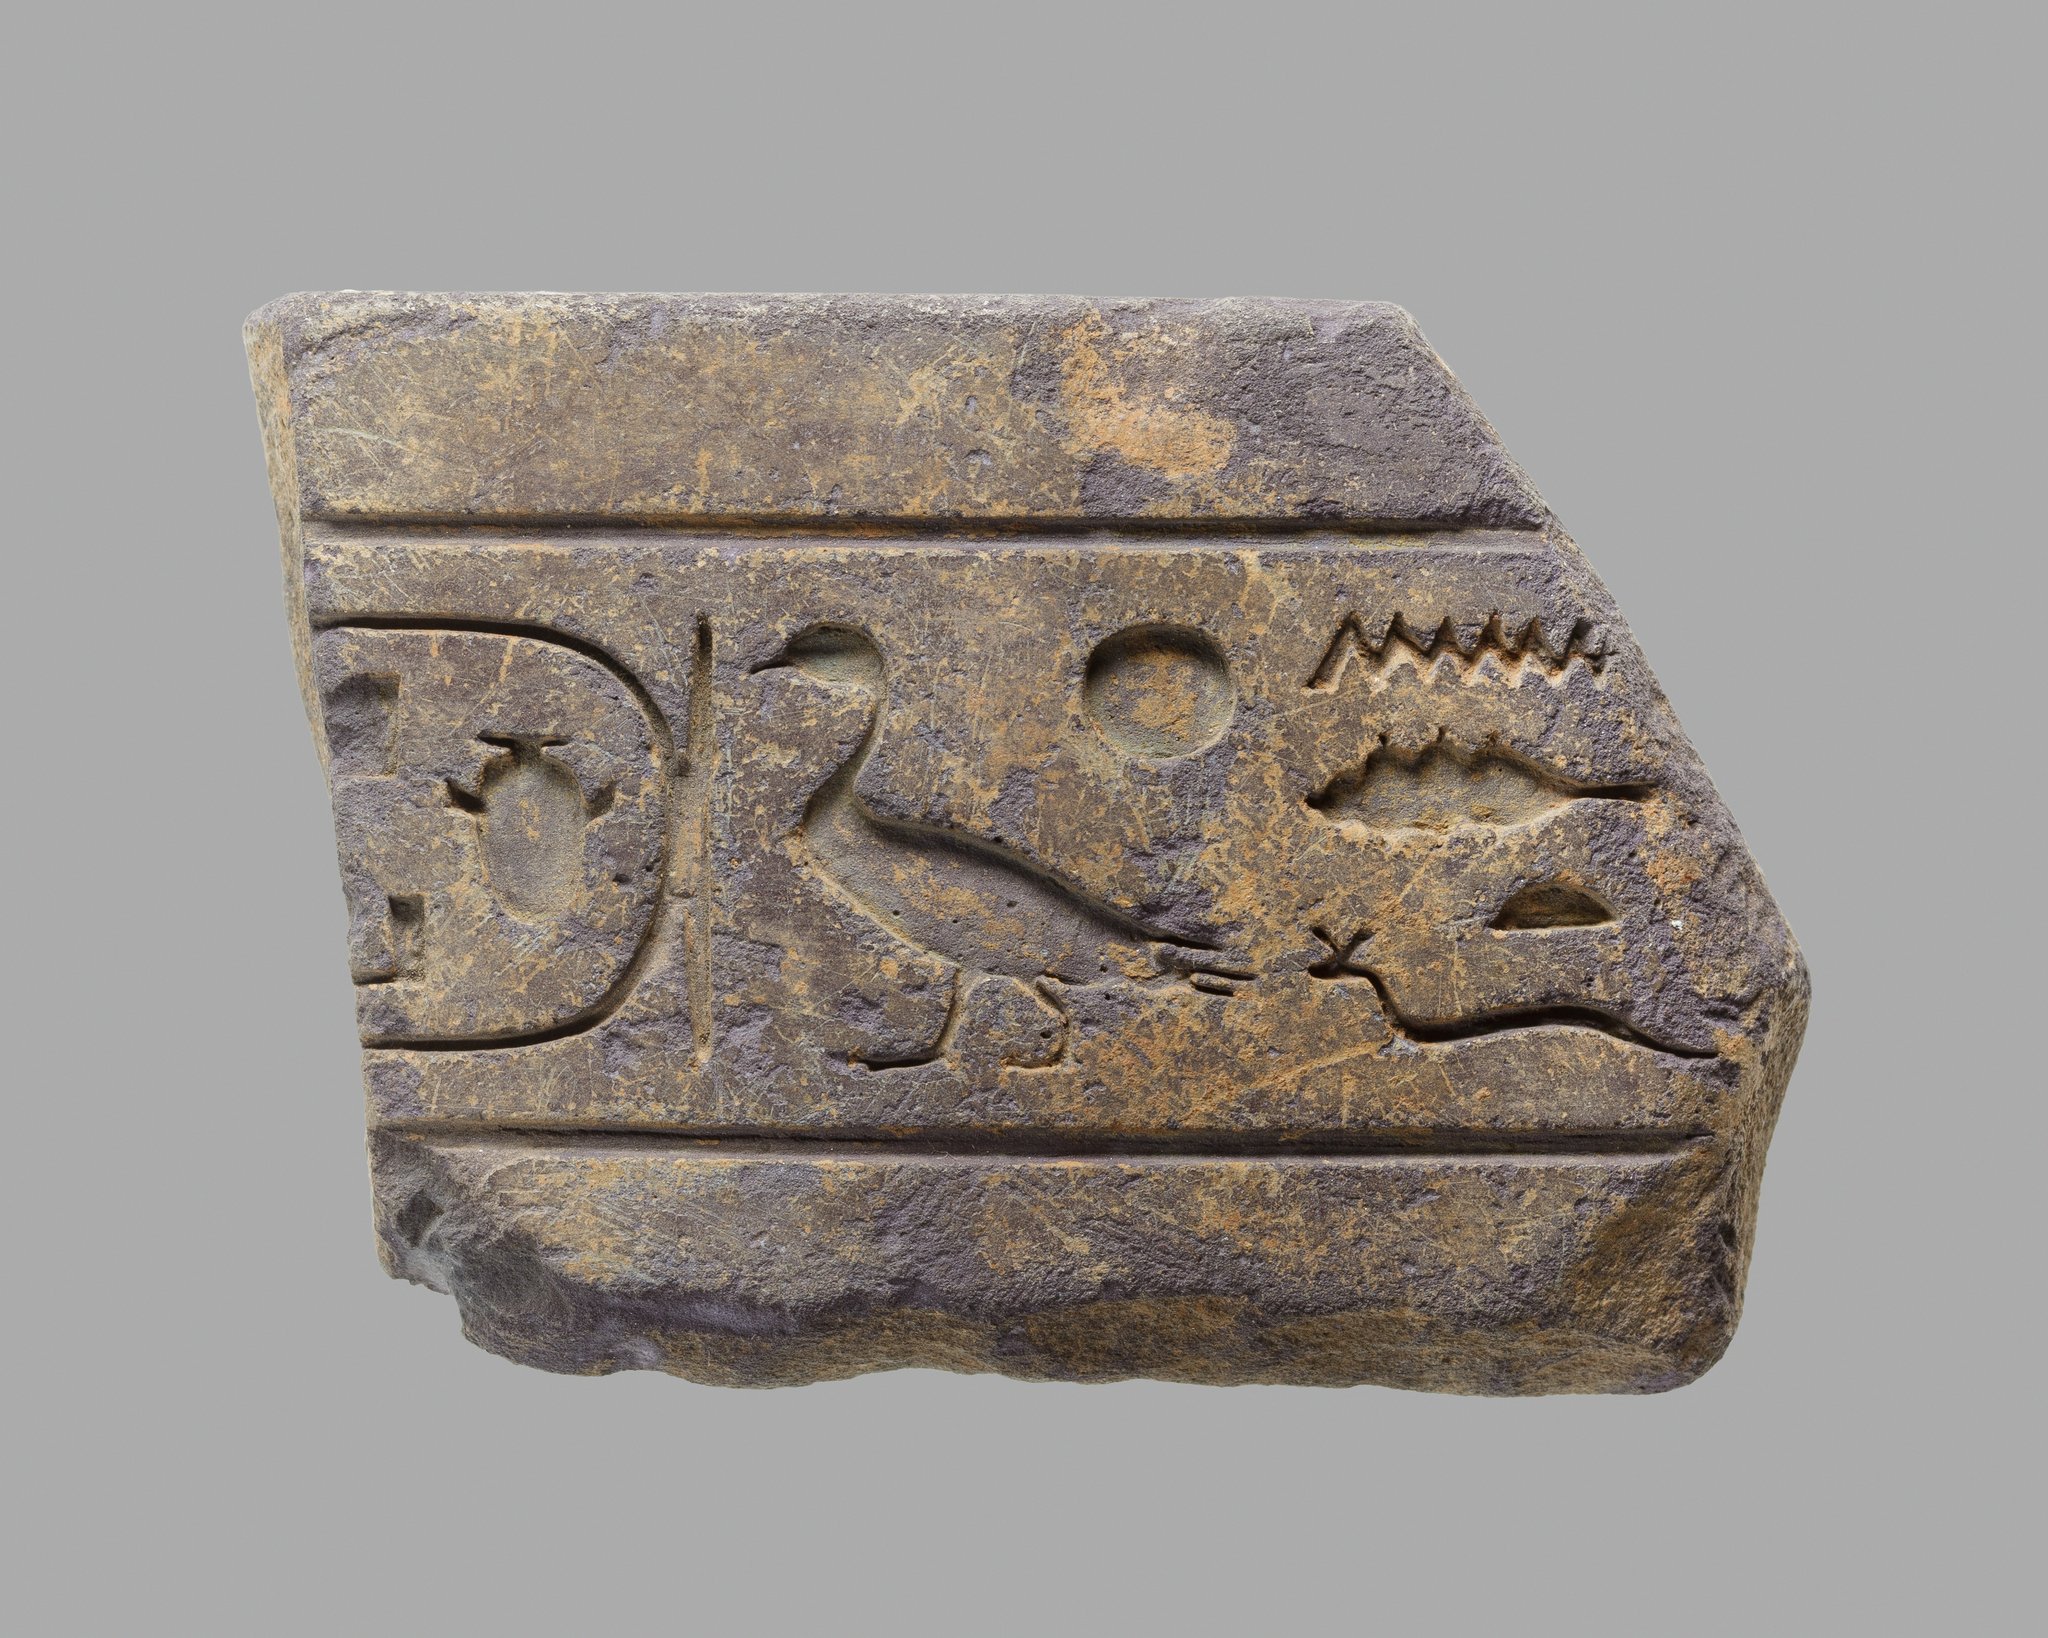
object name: dish fragment, apries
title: Basin fragment with the name of Apries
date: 589-570 BCE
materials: stone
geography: egypt